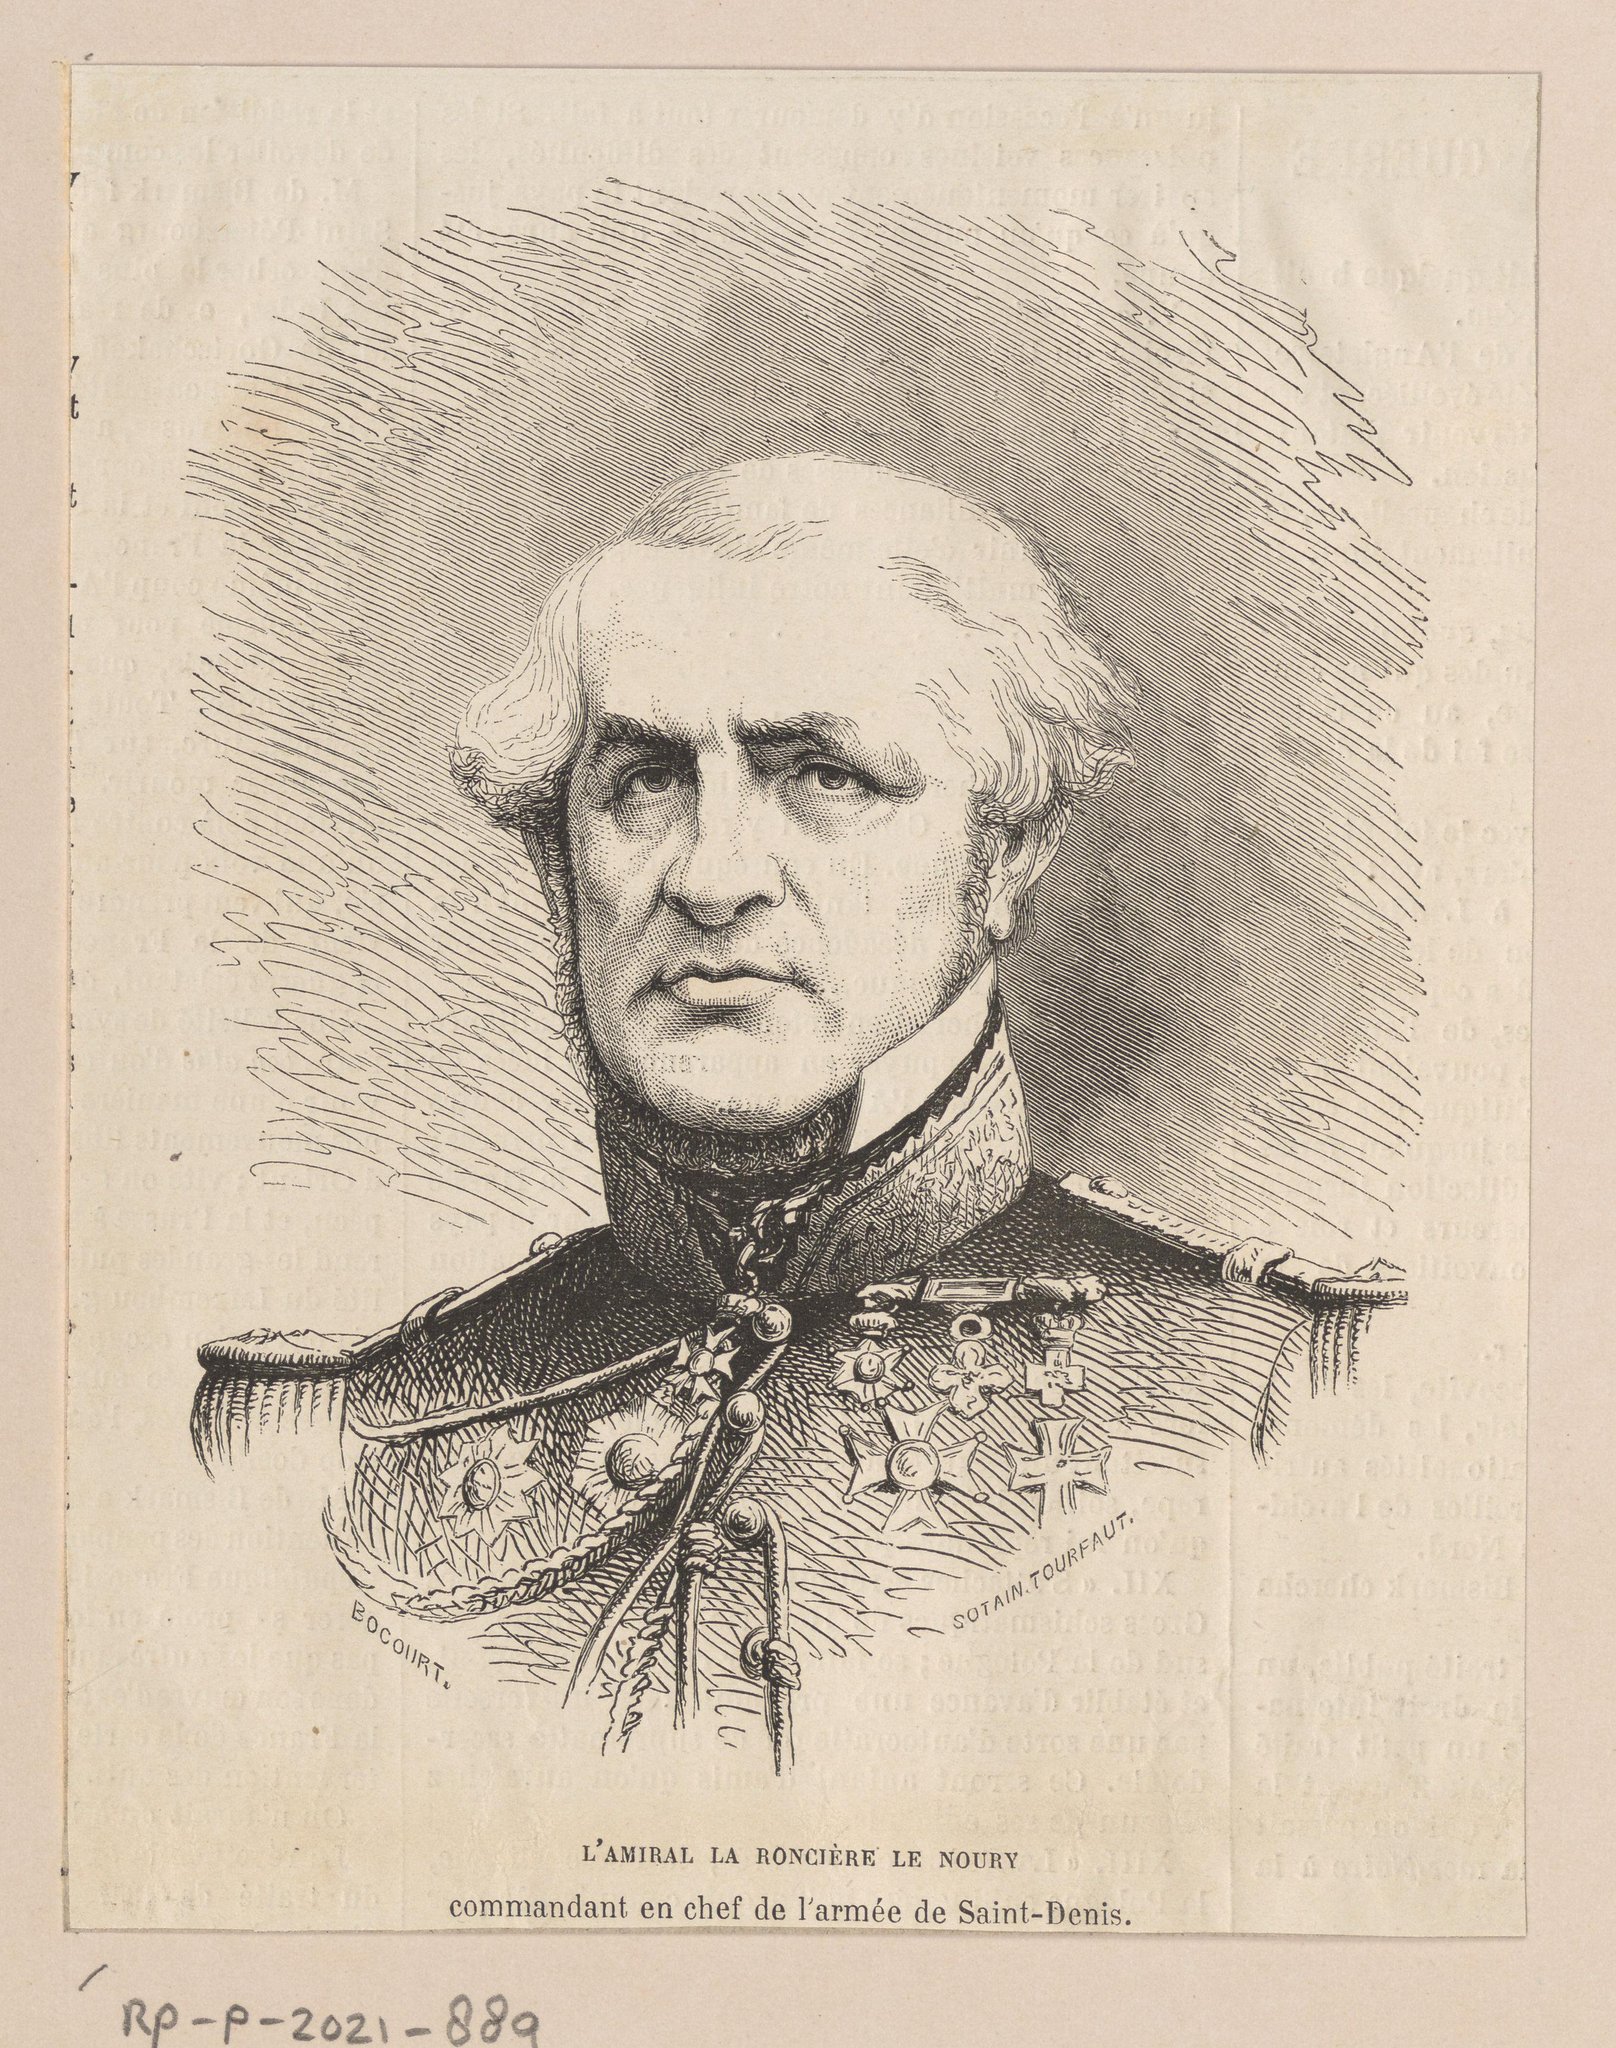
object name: print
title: Portret van Camille Clément de La Roncière-Le Noury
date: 1870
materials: paper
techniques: letterpress printing, engraving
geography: france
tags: paris, naval officer, commander-in-chief, general, marshal, historical persons, (military) uniforms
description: Prent uit: Le Monde Illustré 14 (1870), nr. 716, 31 december 1870, p. 421.